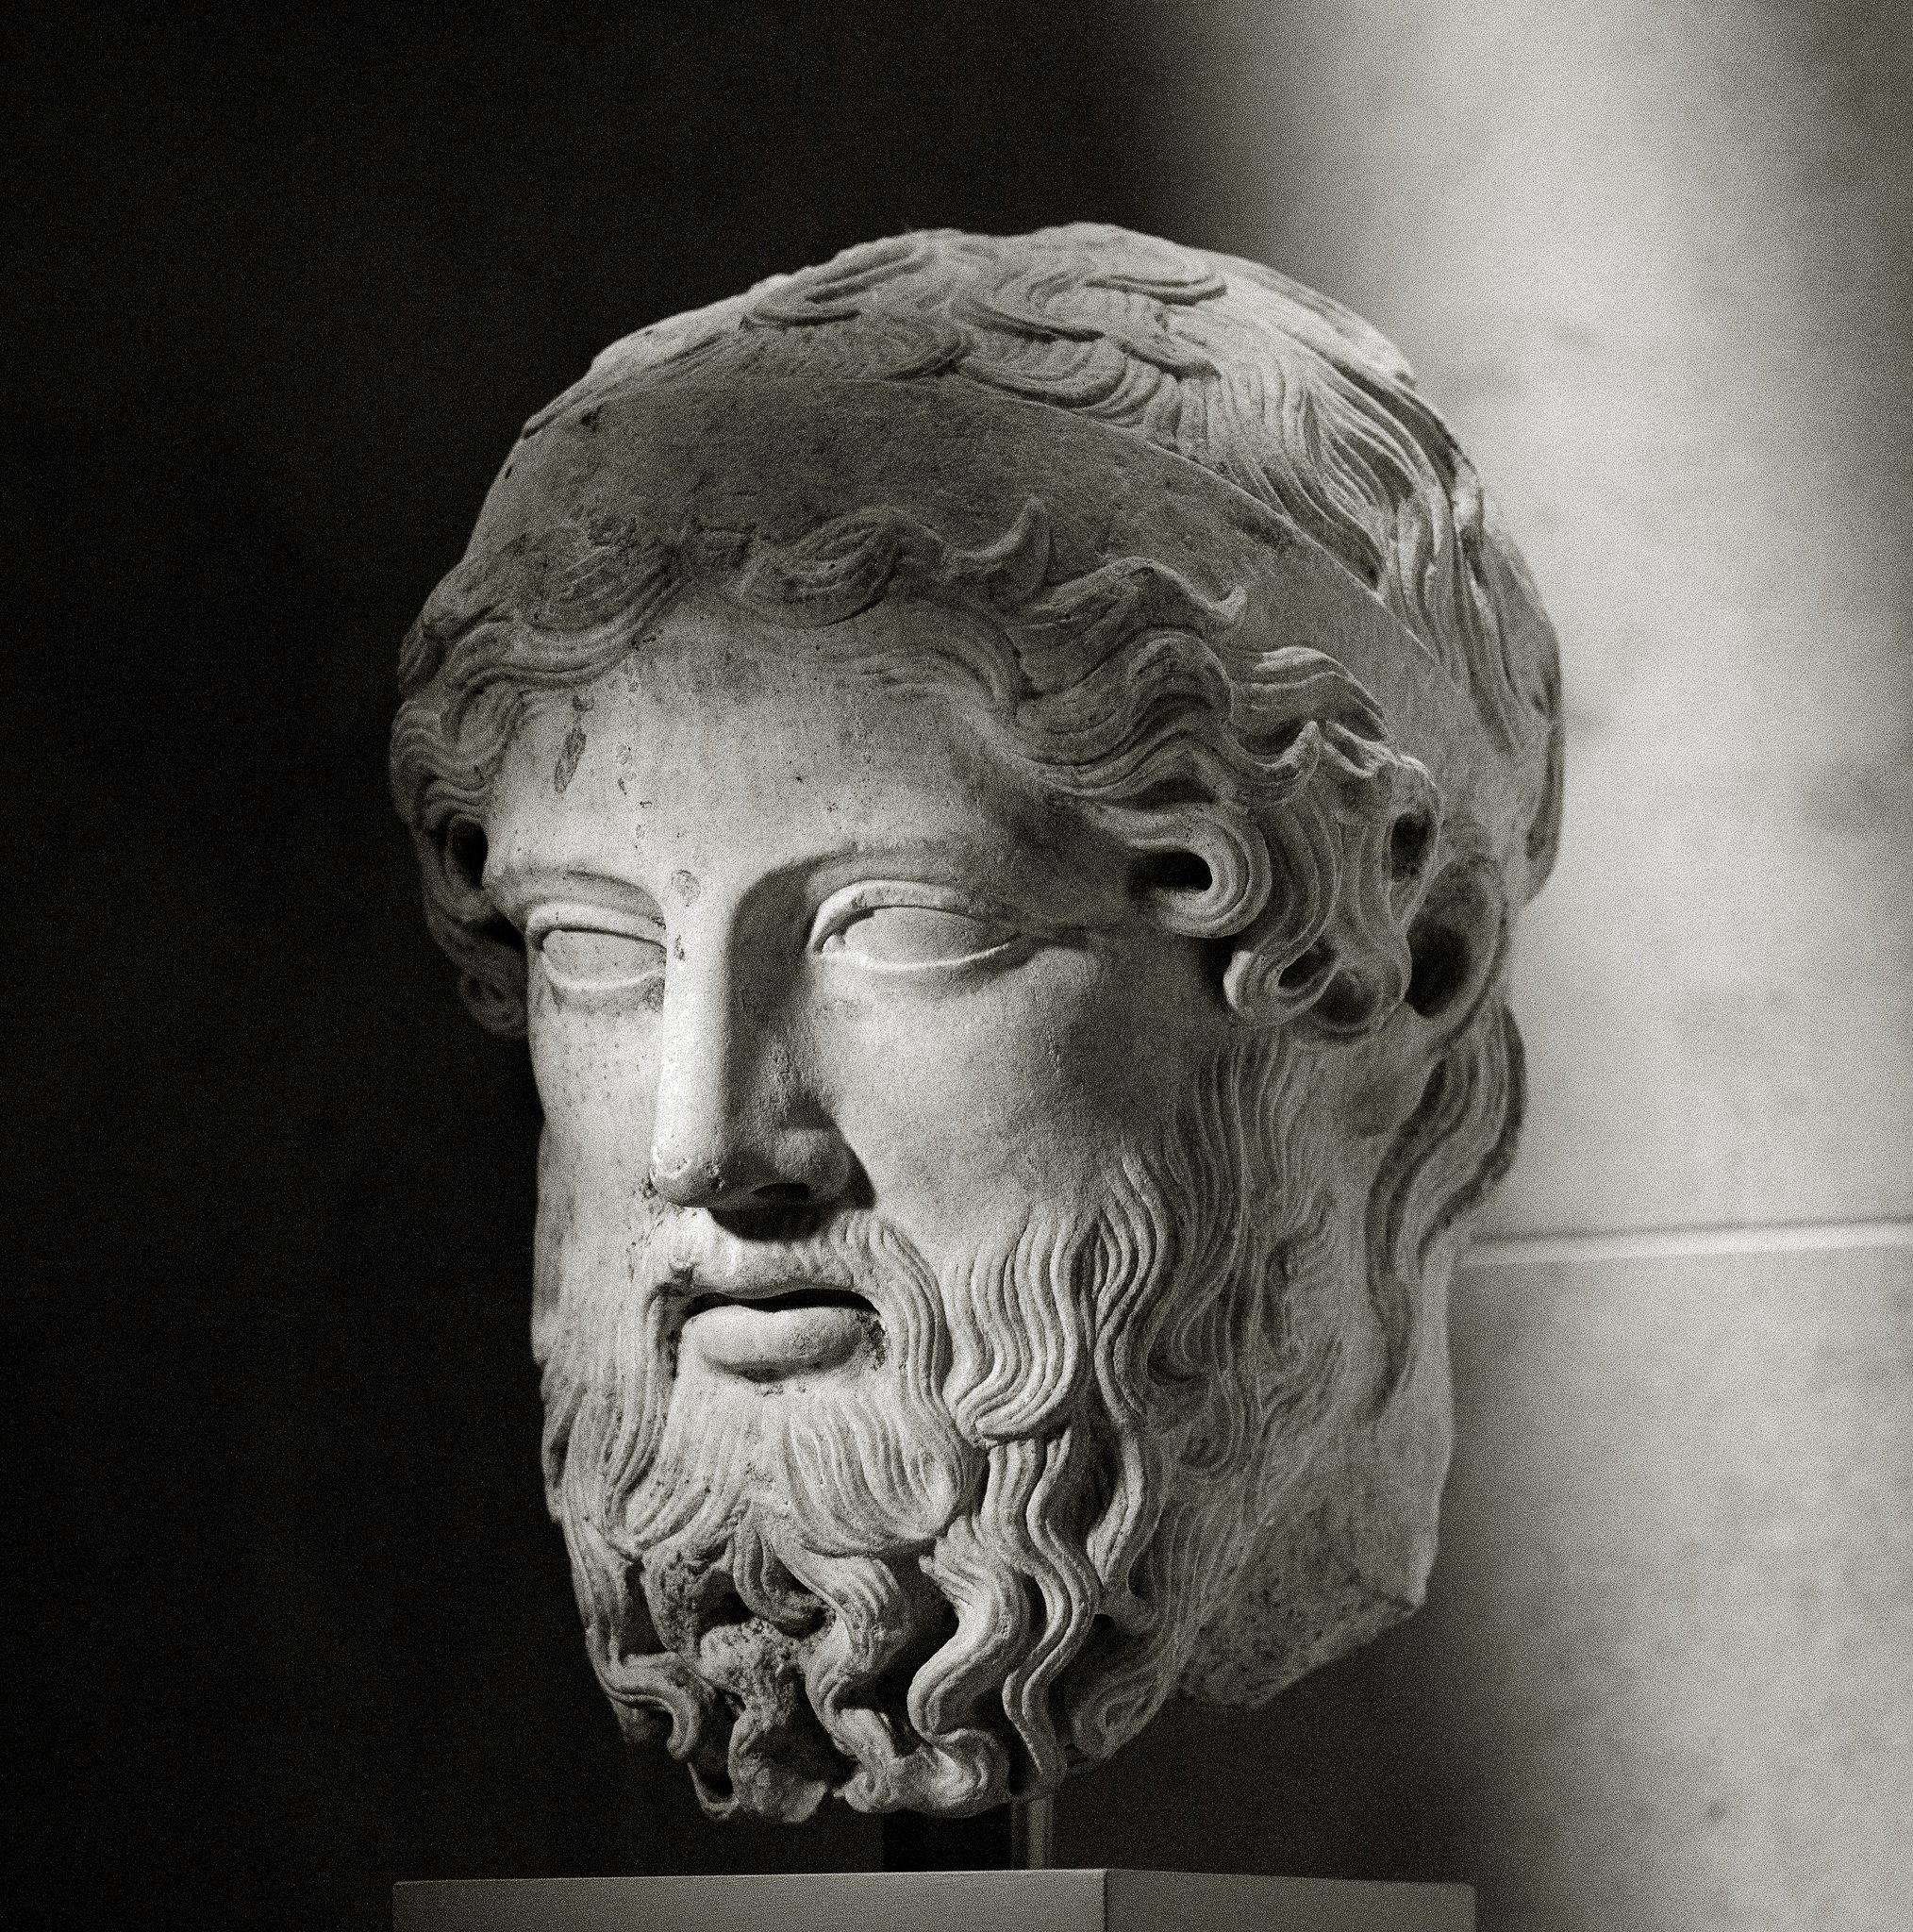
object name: head from a herm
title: Marble head from a herm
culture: roman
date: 1-200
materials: marble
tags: heads,hermes